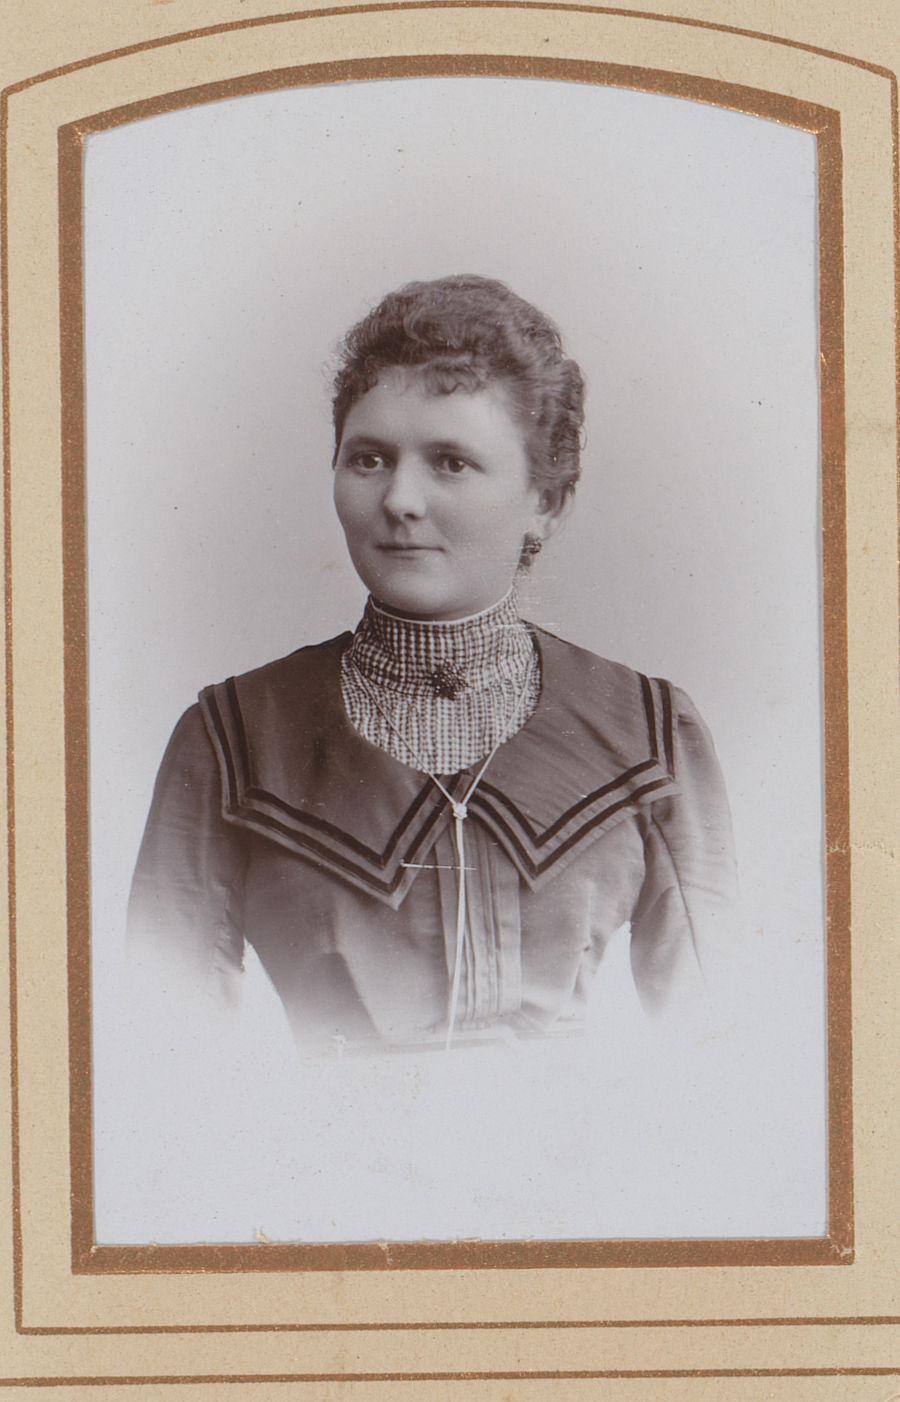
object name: photograph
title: Portret van een vrouw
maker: hermann meyer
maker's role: fotograaf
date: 1890-1910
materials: cardboard, photographic support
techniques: collodion silver print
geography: senftenberg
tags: historical persons - bb - woman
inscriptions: inscription: ‘Herm. Meyer/ Senftenberg, N/L.’